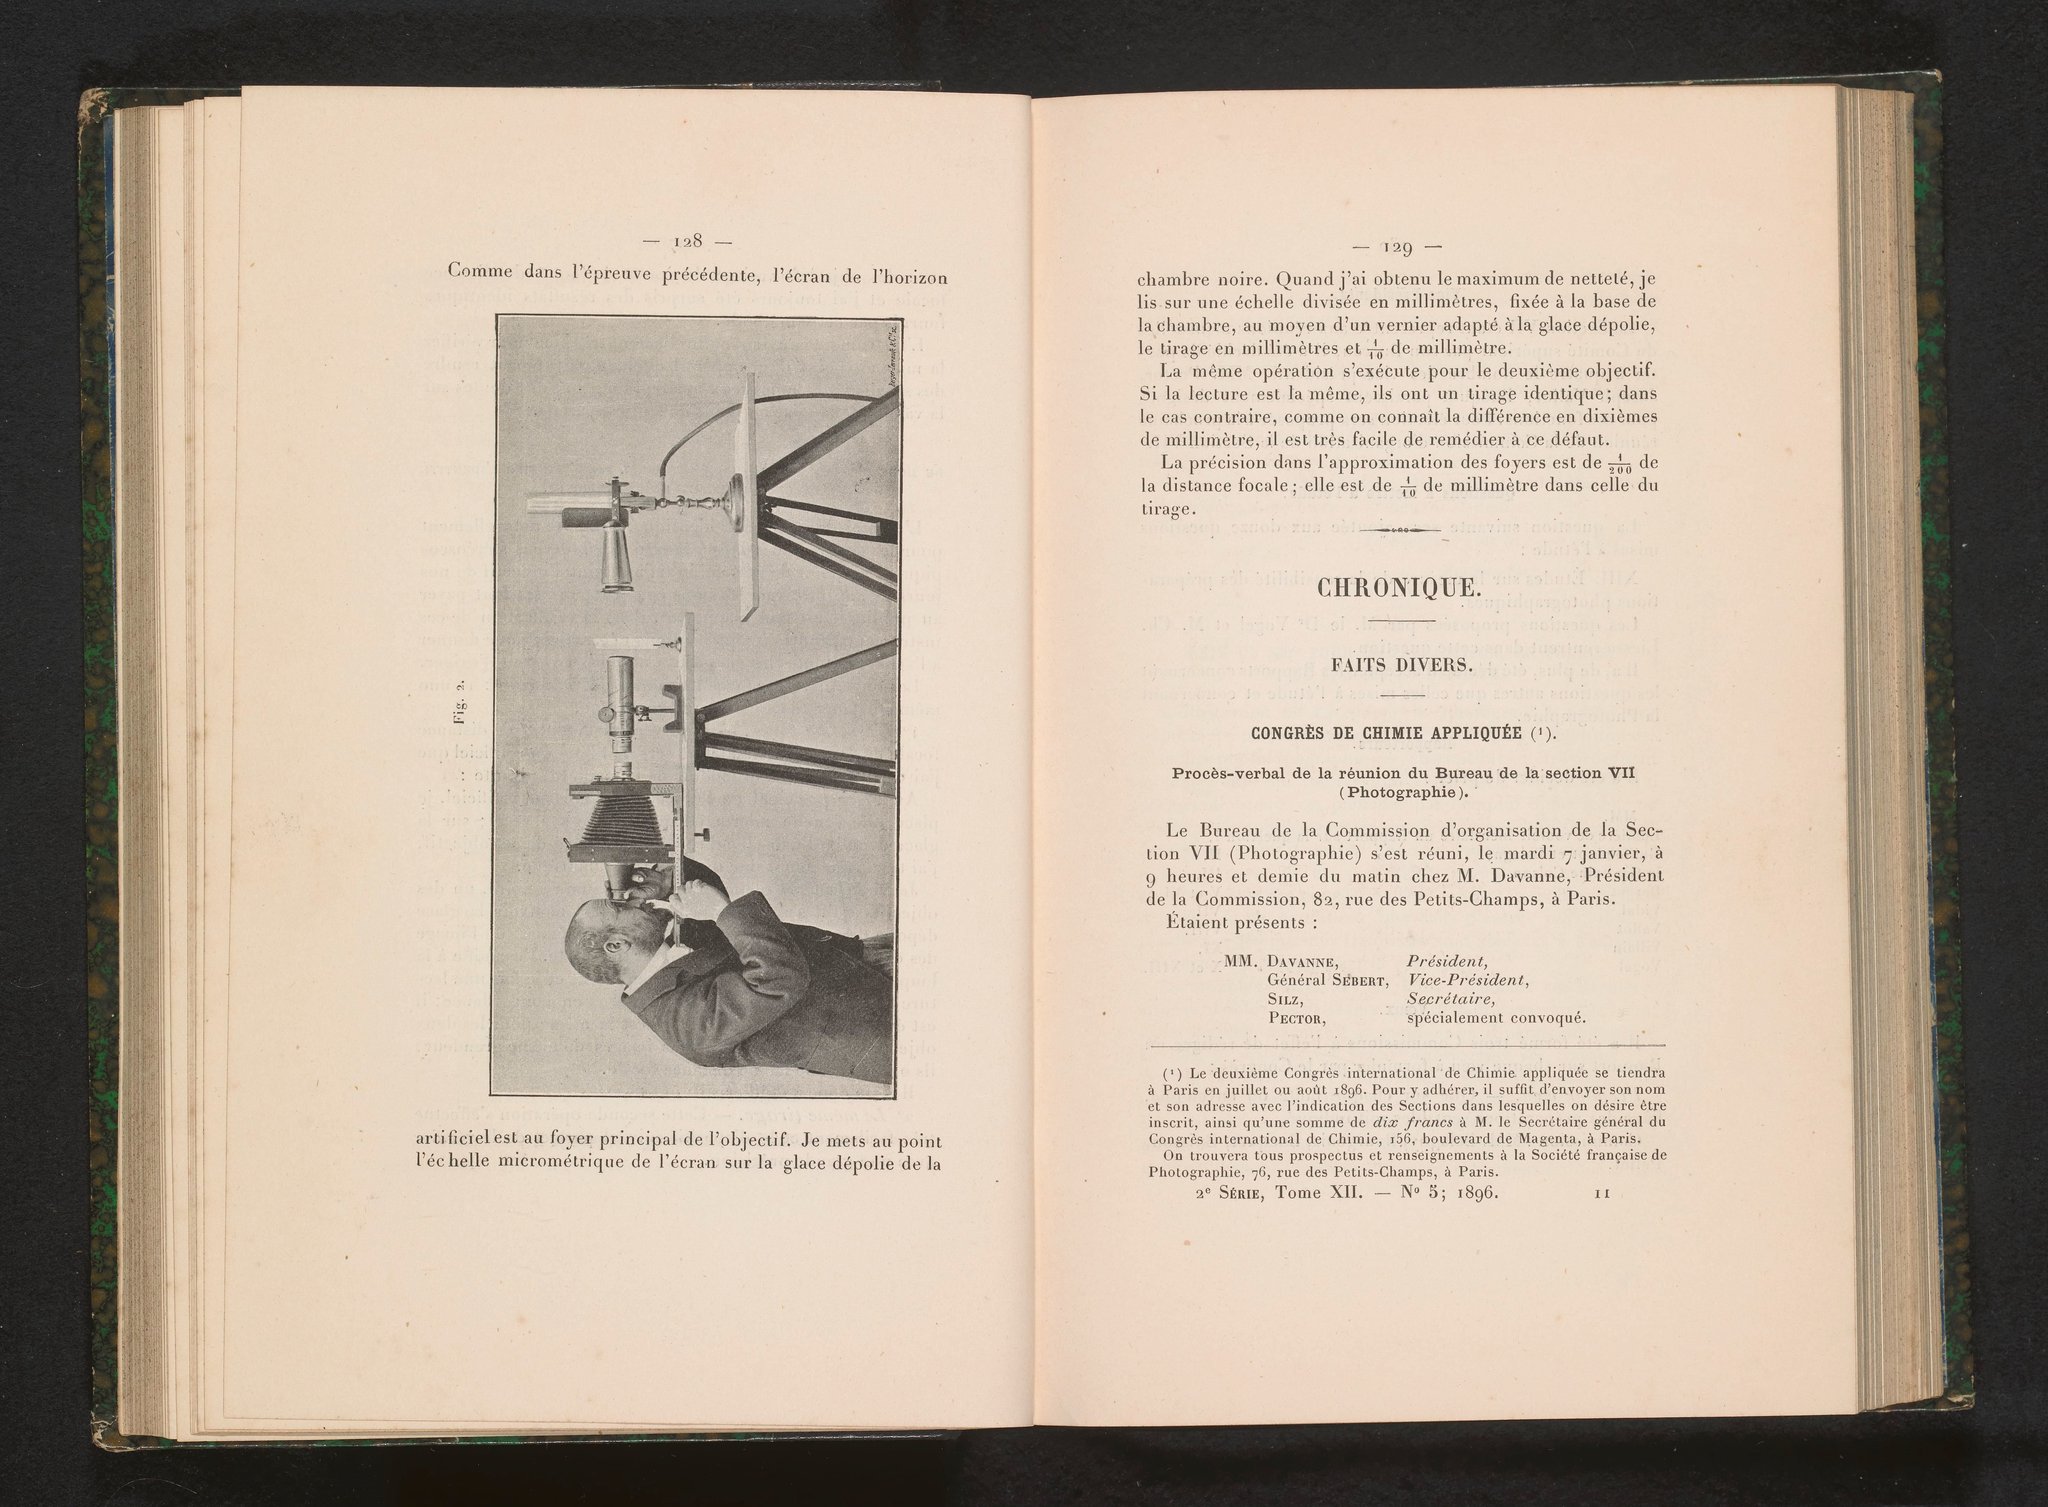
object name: photomechanical print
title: Man met een camera met een objectief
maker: Anonymous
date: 1886-1896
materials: paper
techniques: autotype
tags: camera ~ photography, taking photographs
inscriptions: number: ‘Fig. 2.’